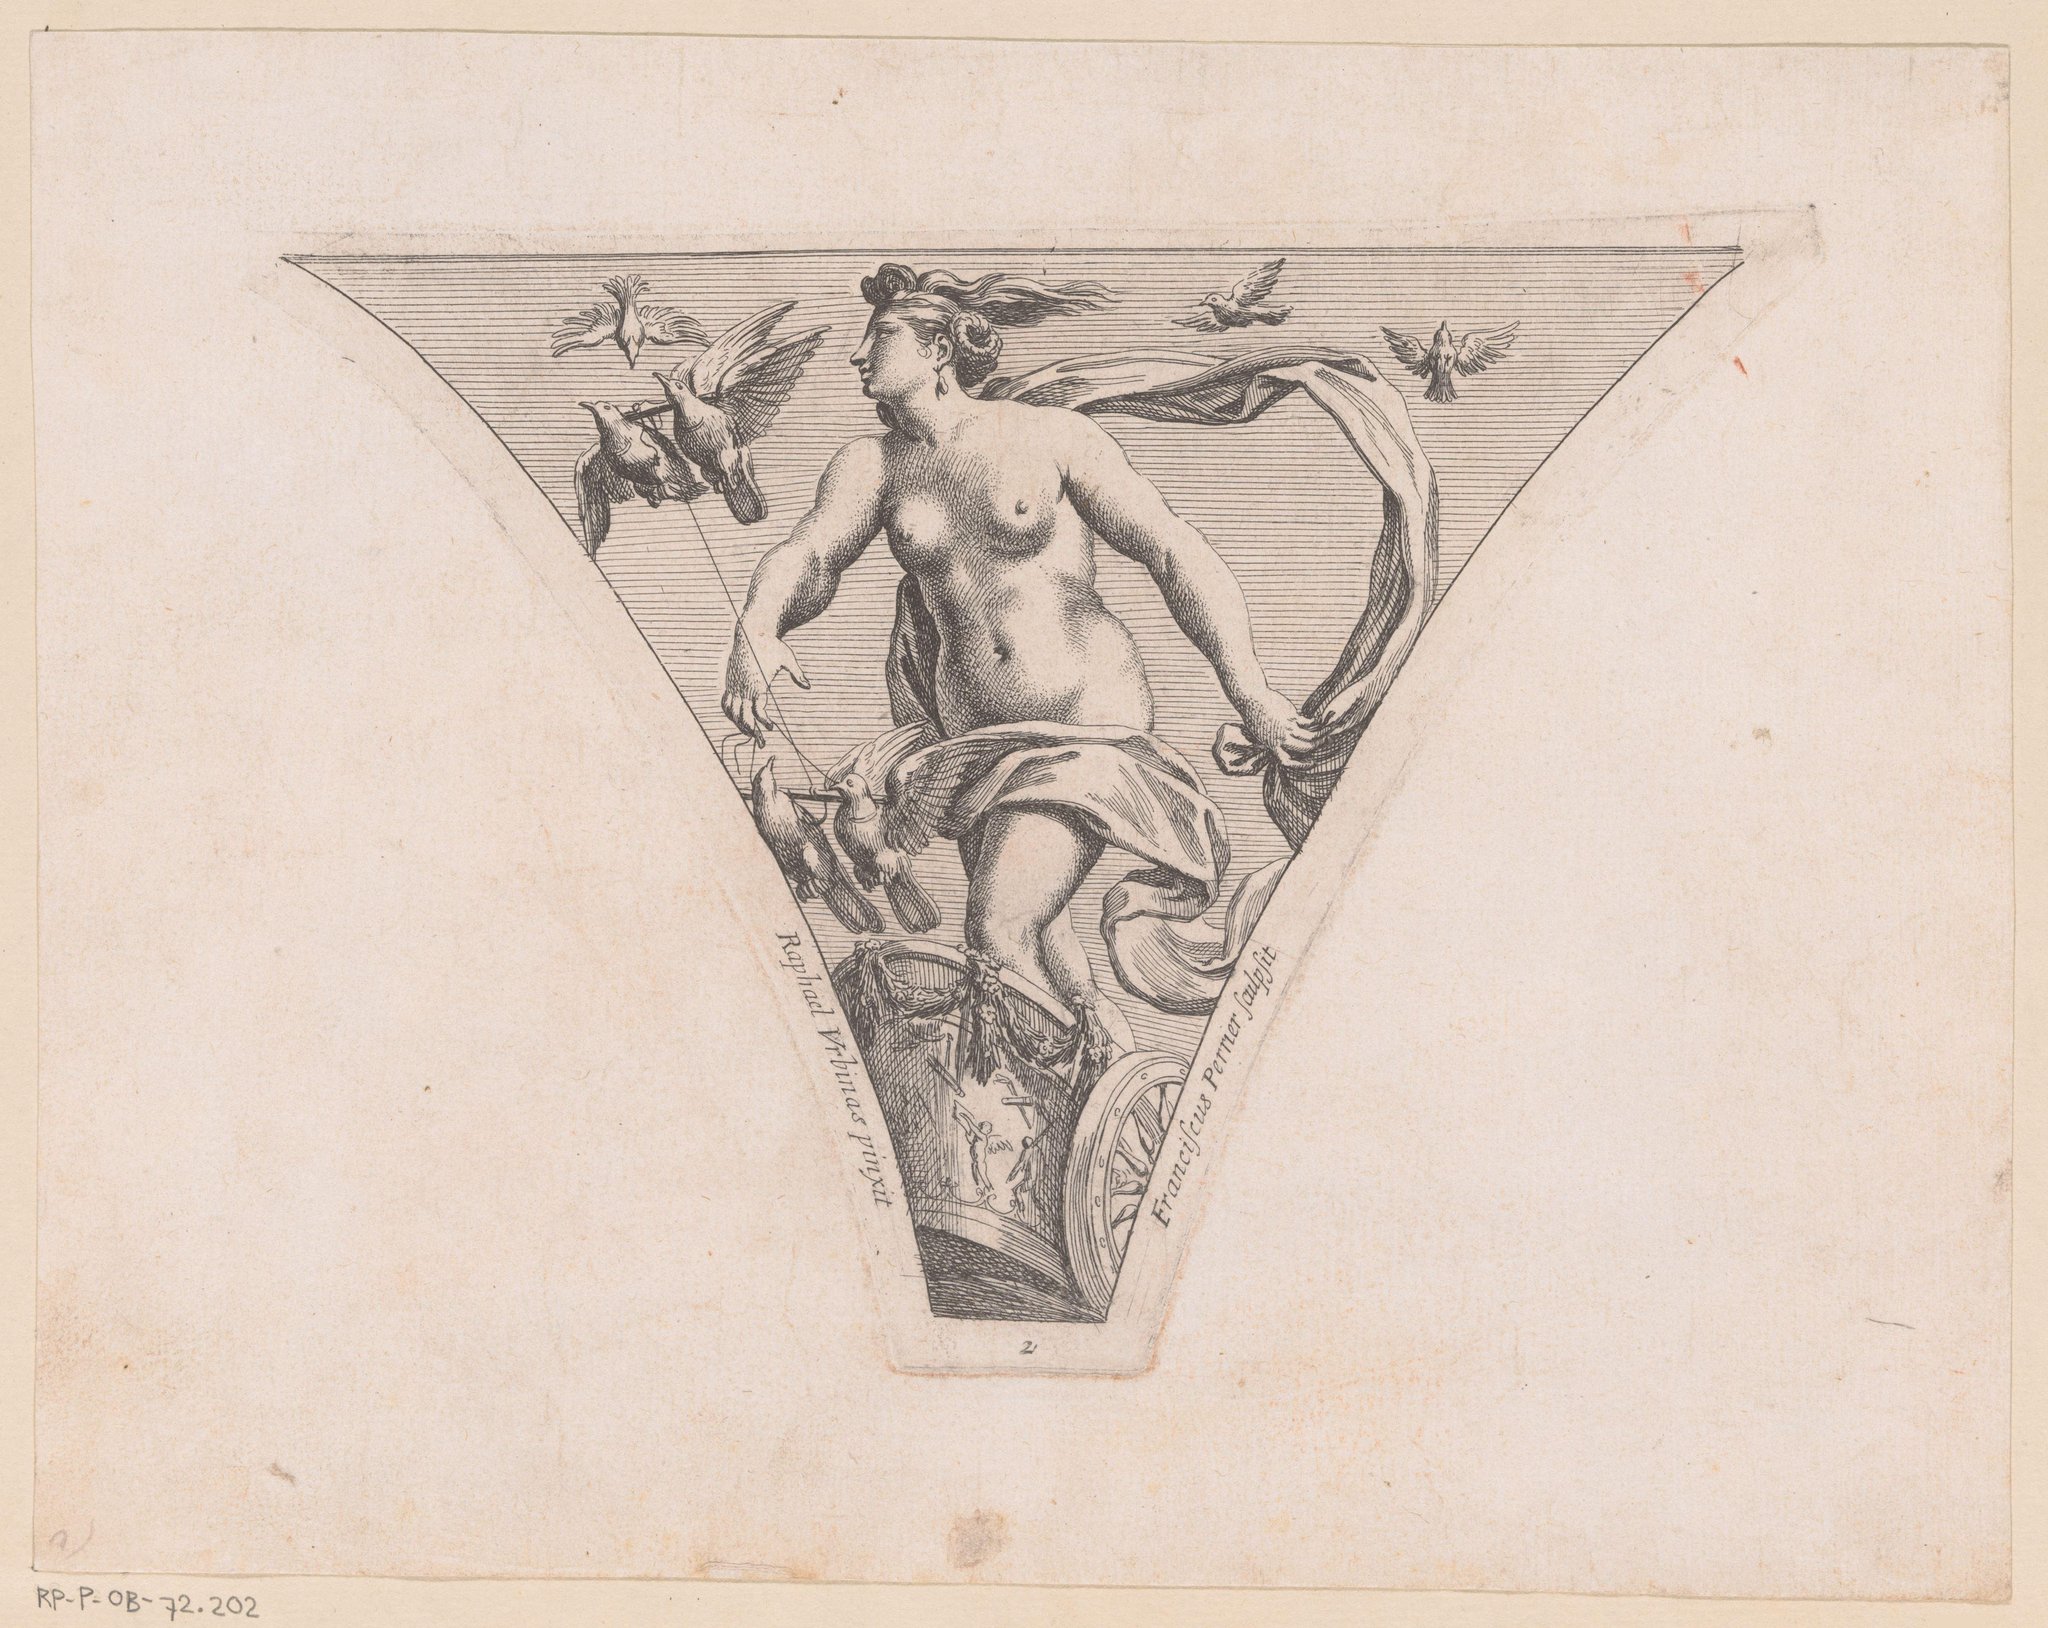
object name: print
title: Fresco's van Rafaël in de Villa Farnesina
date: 1624-1649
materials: paper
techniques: etching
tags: (story of) venus (aphrodite)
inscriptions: collector's mark: Lugt 240